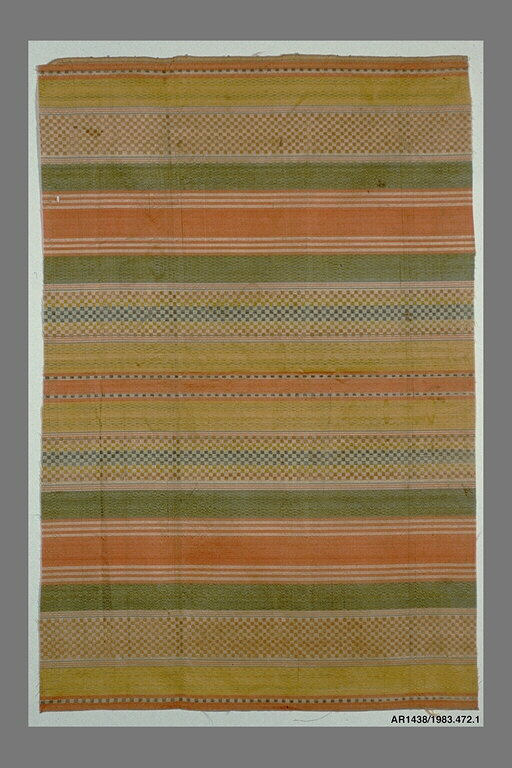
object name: piece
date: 1780-1789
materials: silk